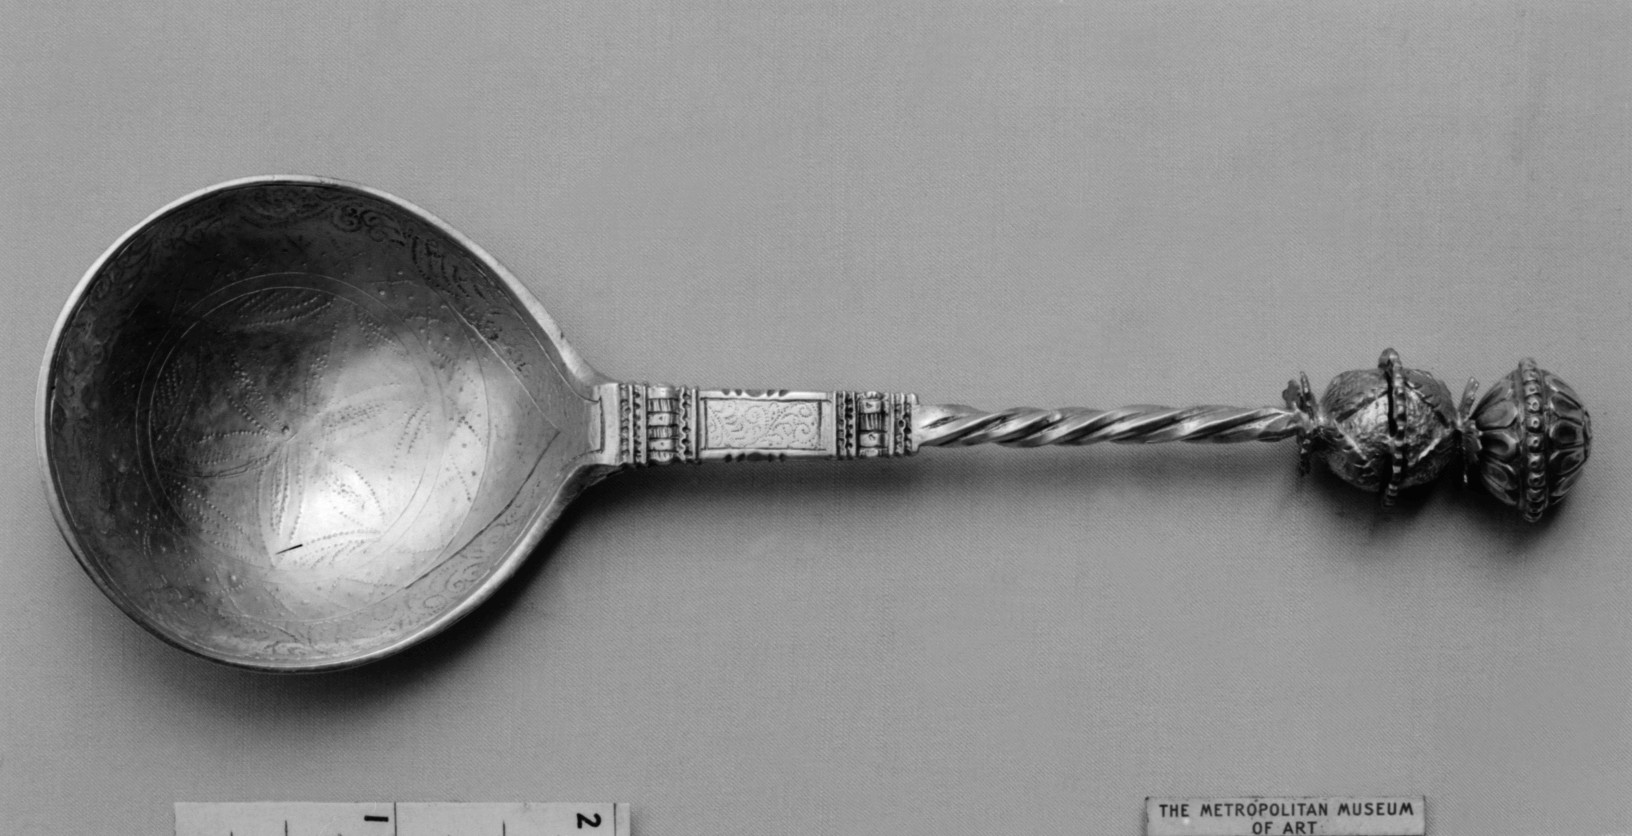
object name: spoon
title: Ball-topped spoon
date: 1834-1866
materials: gilt, silver